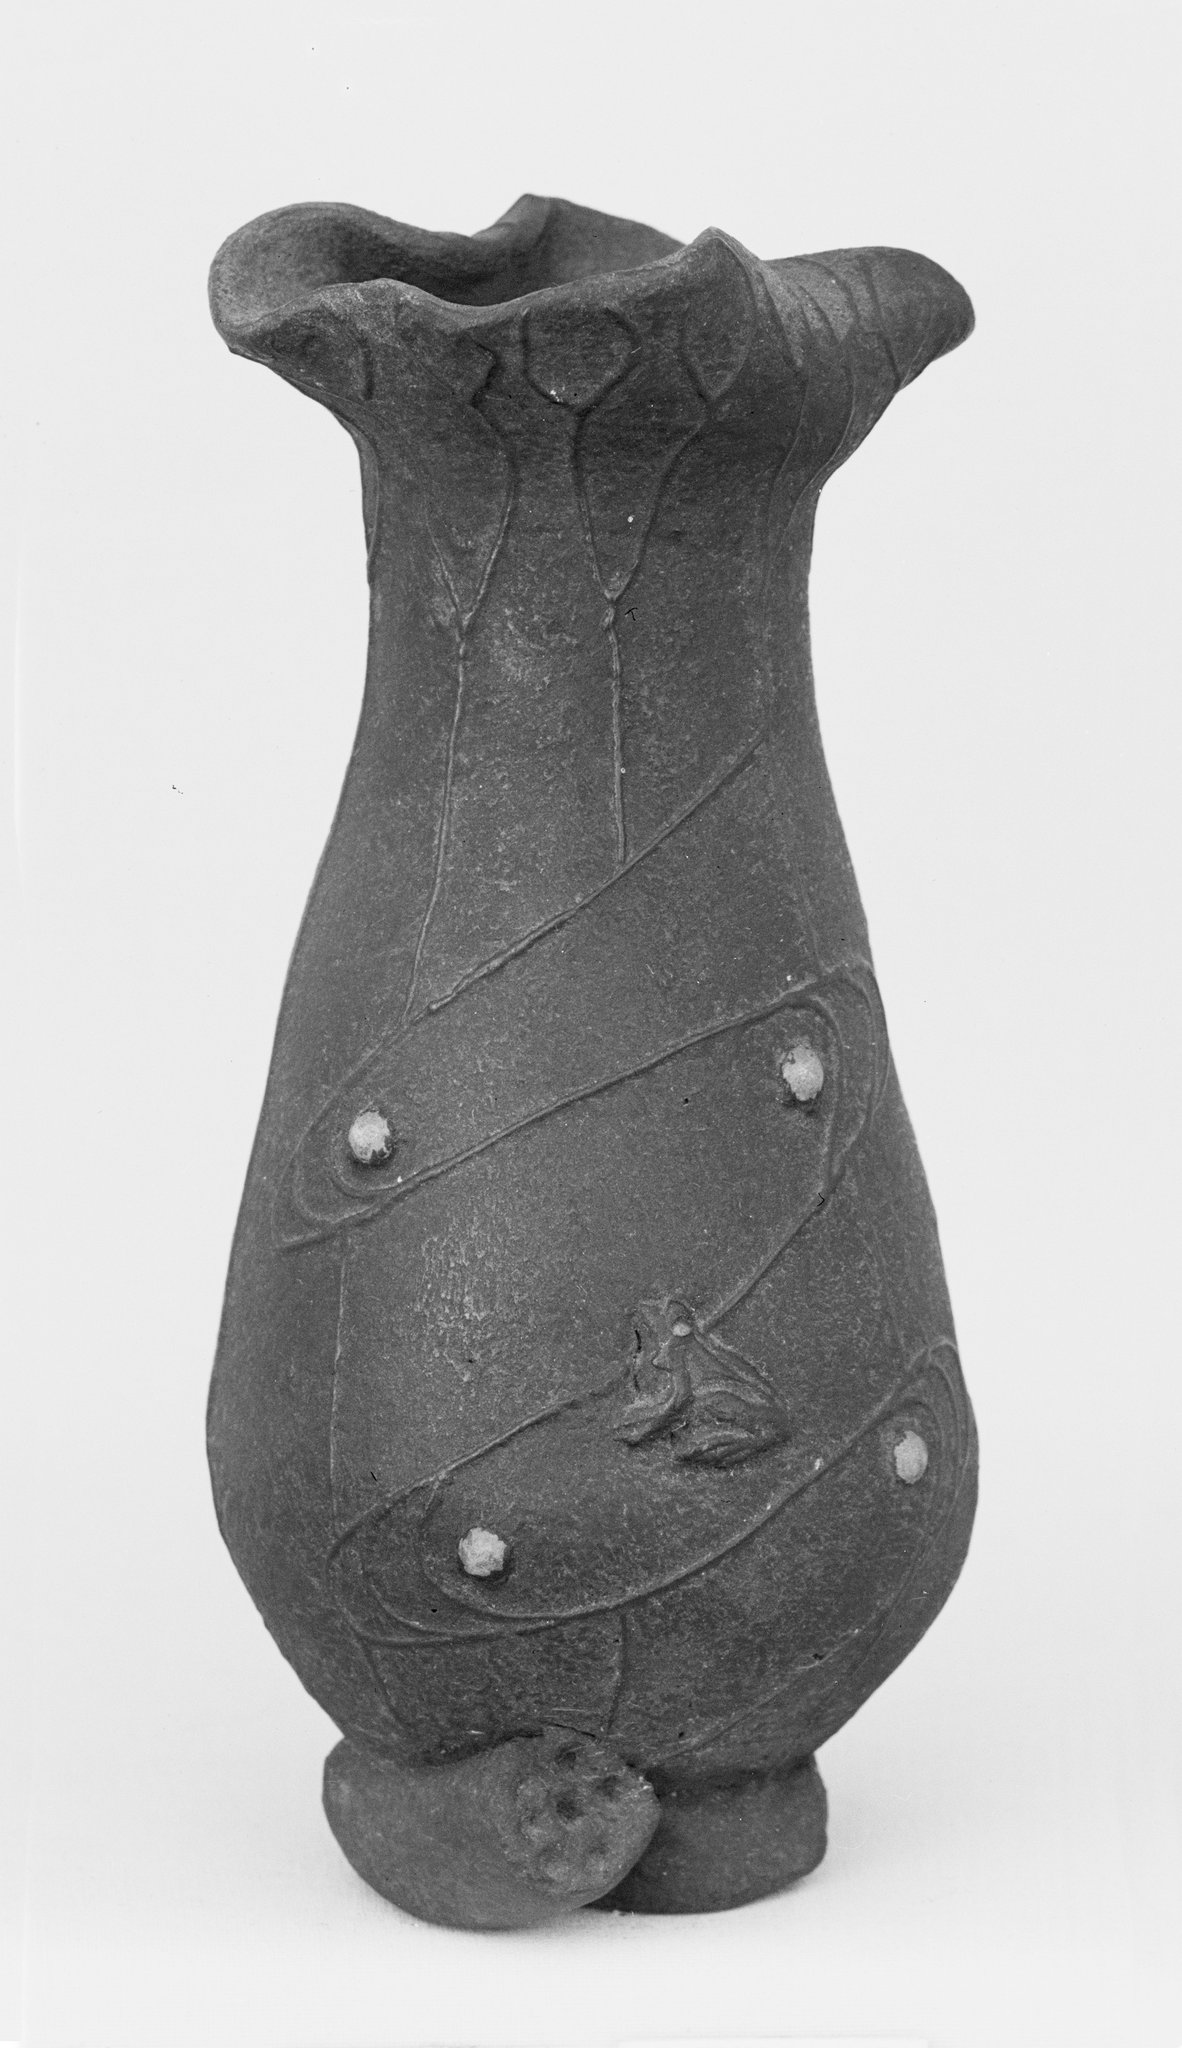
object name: hanging vase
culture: japanese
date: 1801-1900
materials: glaze, pottery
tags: frogs